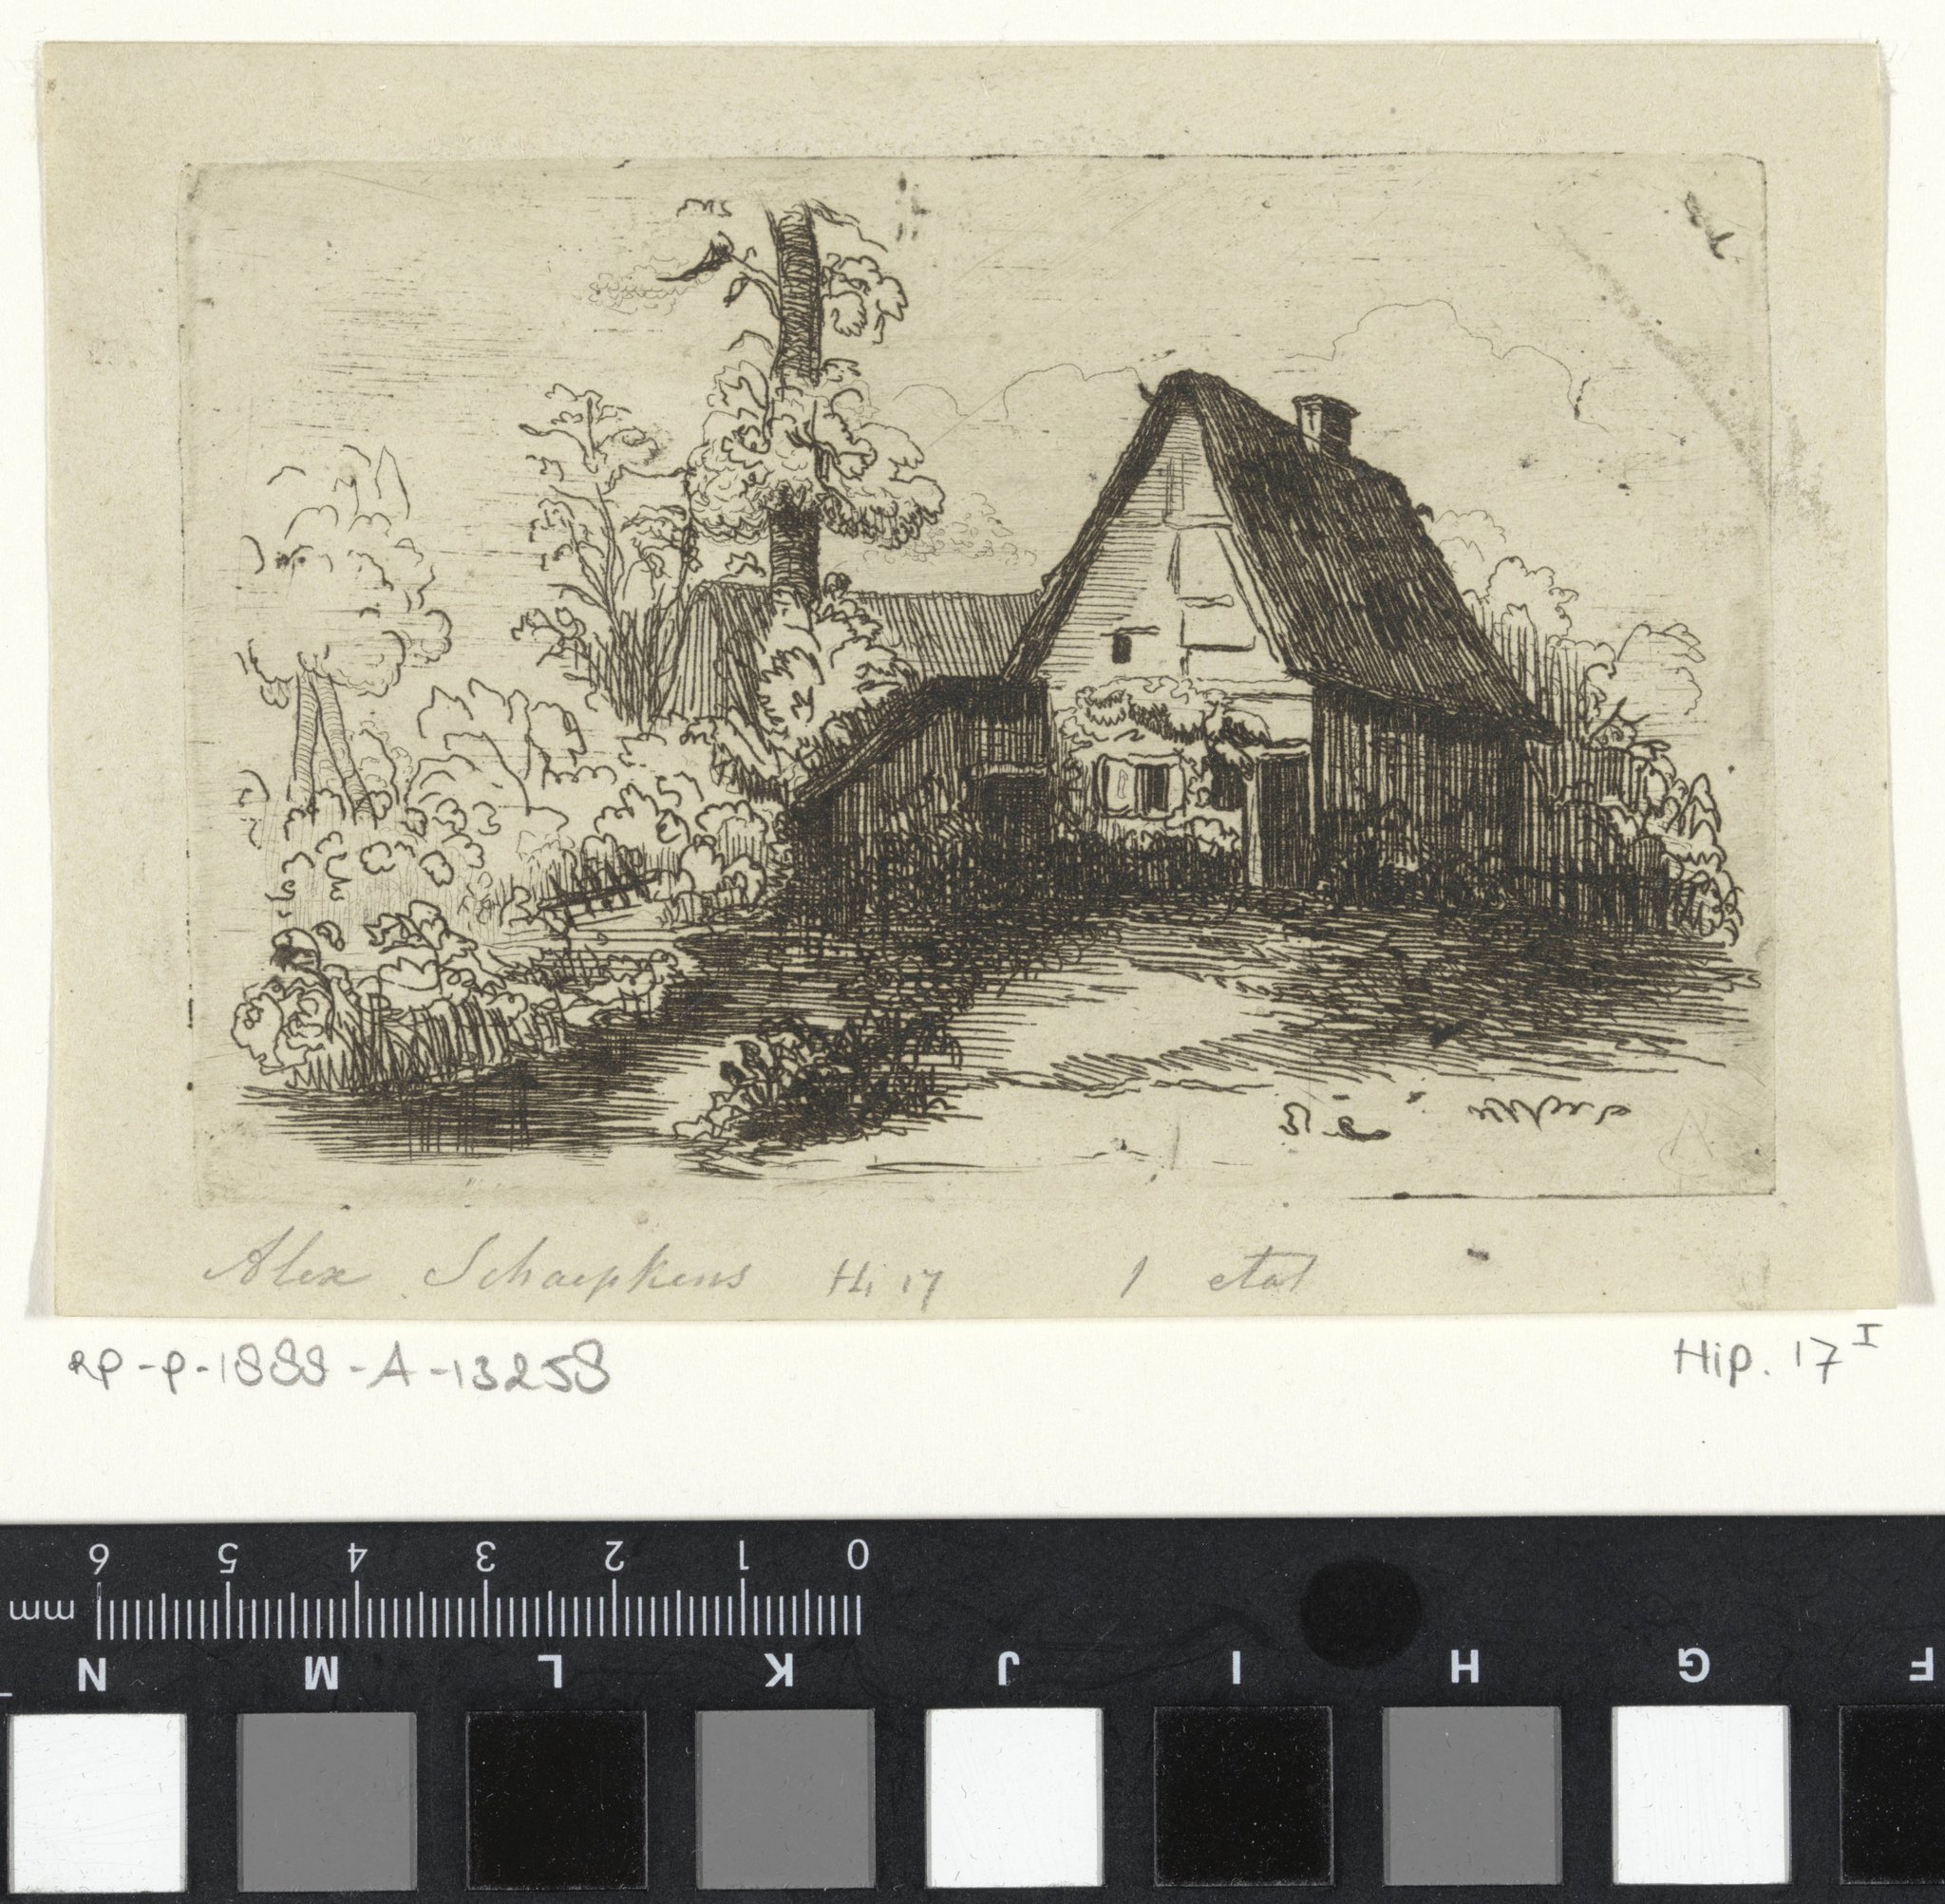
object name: print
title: Boerenhoeve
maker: alexander schaepkens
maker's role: draughtsman, print maker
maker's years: 1815-1899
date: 1830-1888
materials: paper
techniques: etching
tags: farm or solitary house in landscape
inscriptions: collector's mark: Lugt 2228